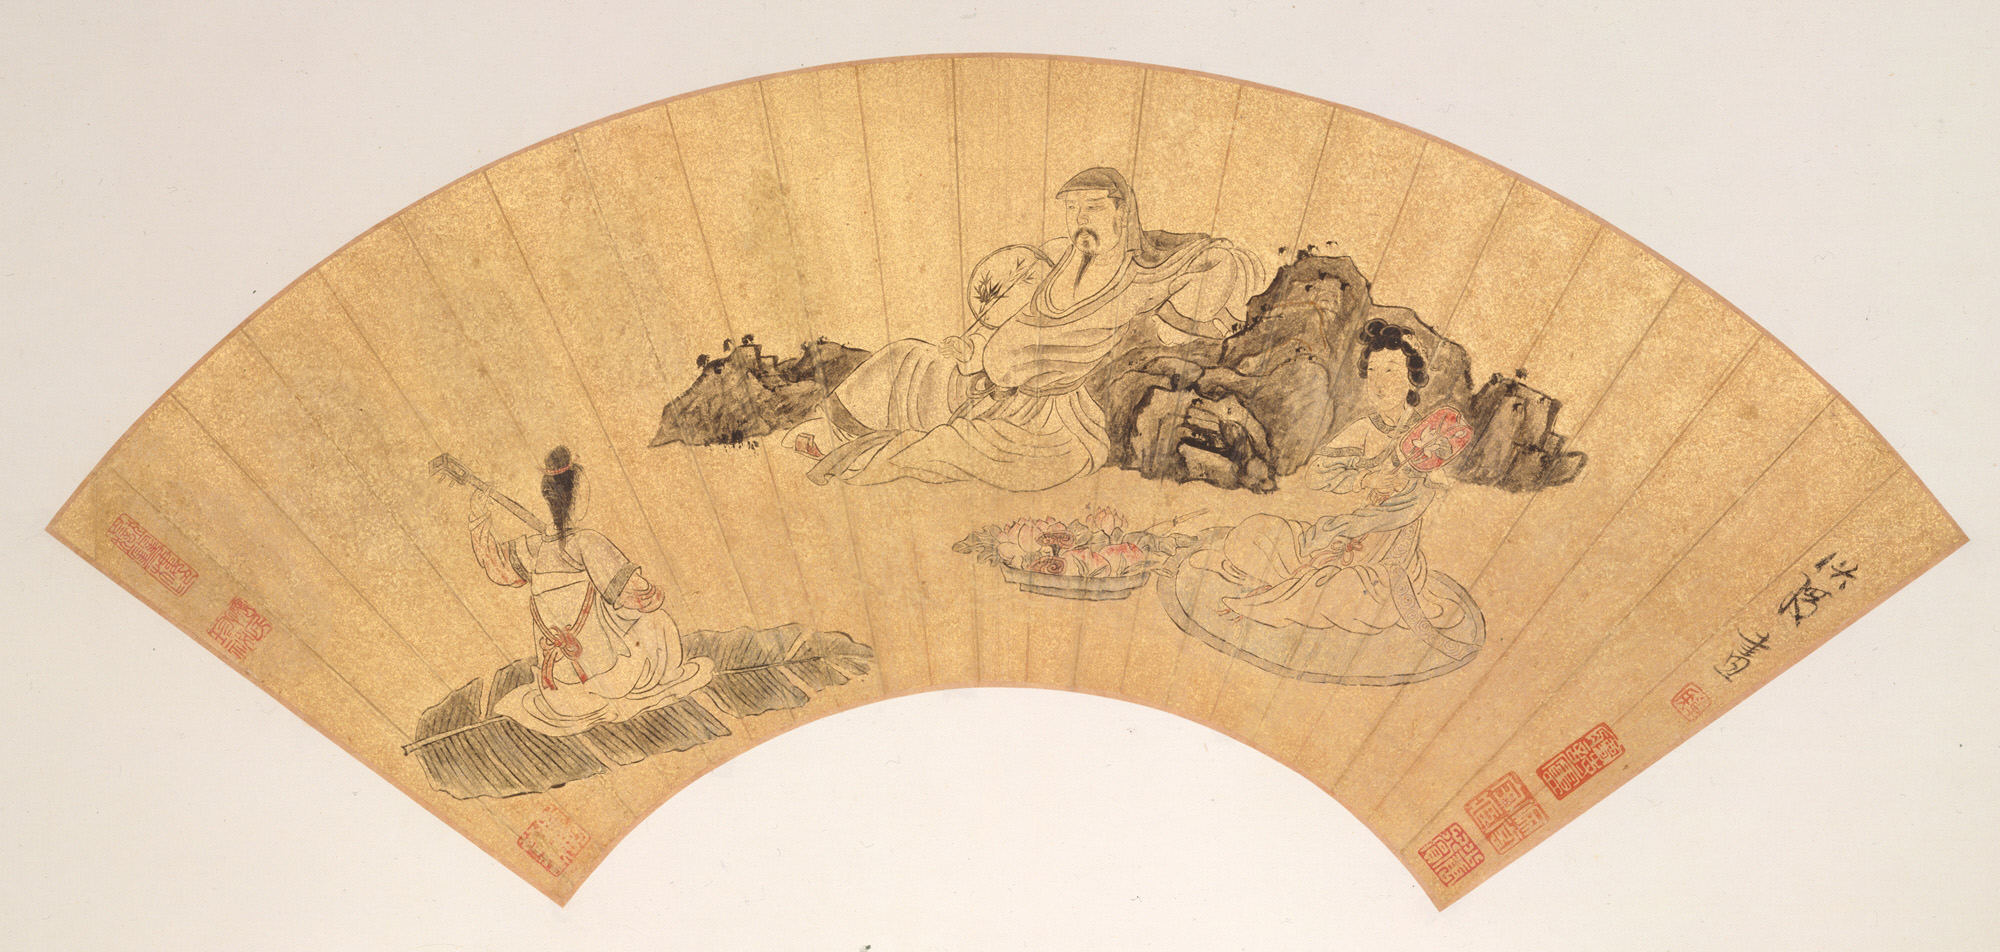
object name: folding fan mounted a an album leaf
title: Landscapes and Flowers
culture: chinese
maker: chen hongshou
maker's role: artist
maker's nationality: chinese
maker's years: 1598-1652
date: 1601-1650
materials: gold, ink, paper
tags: men,landscapes